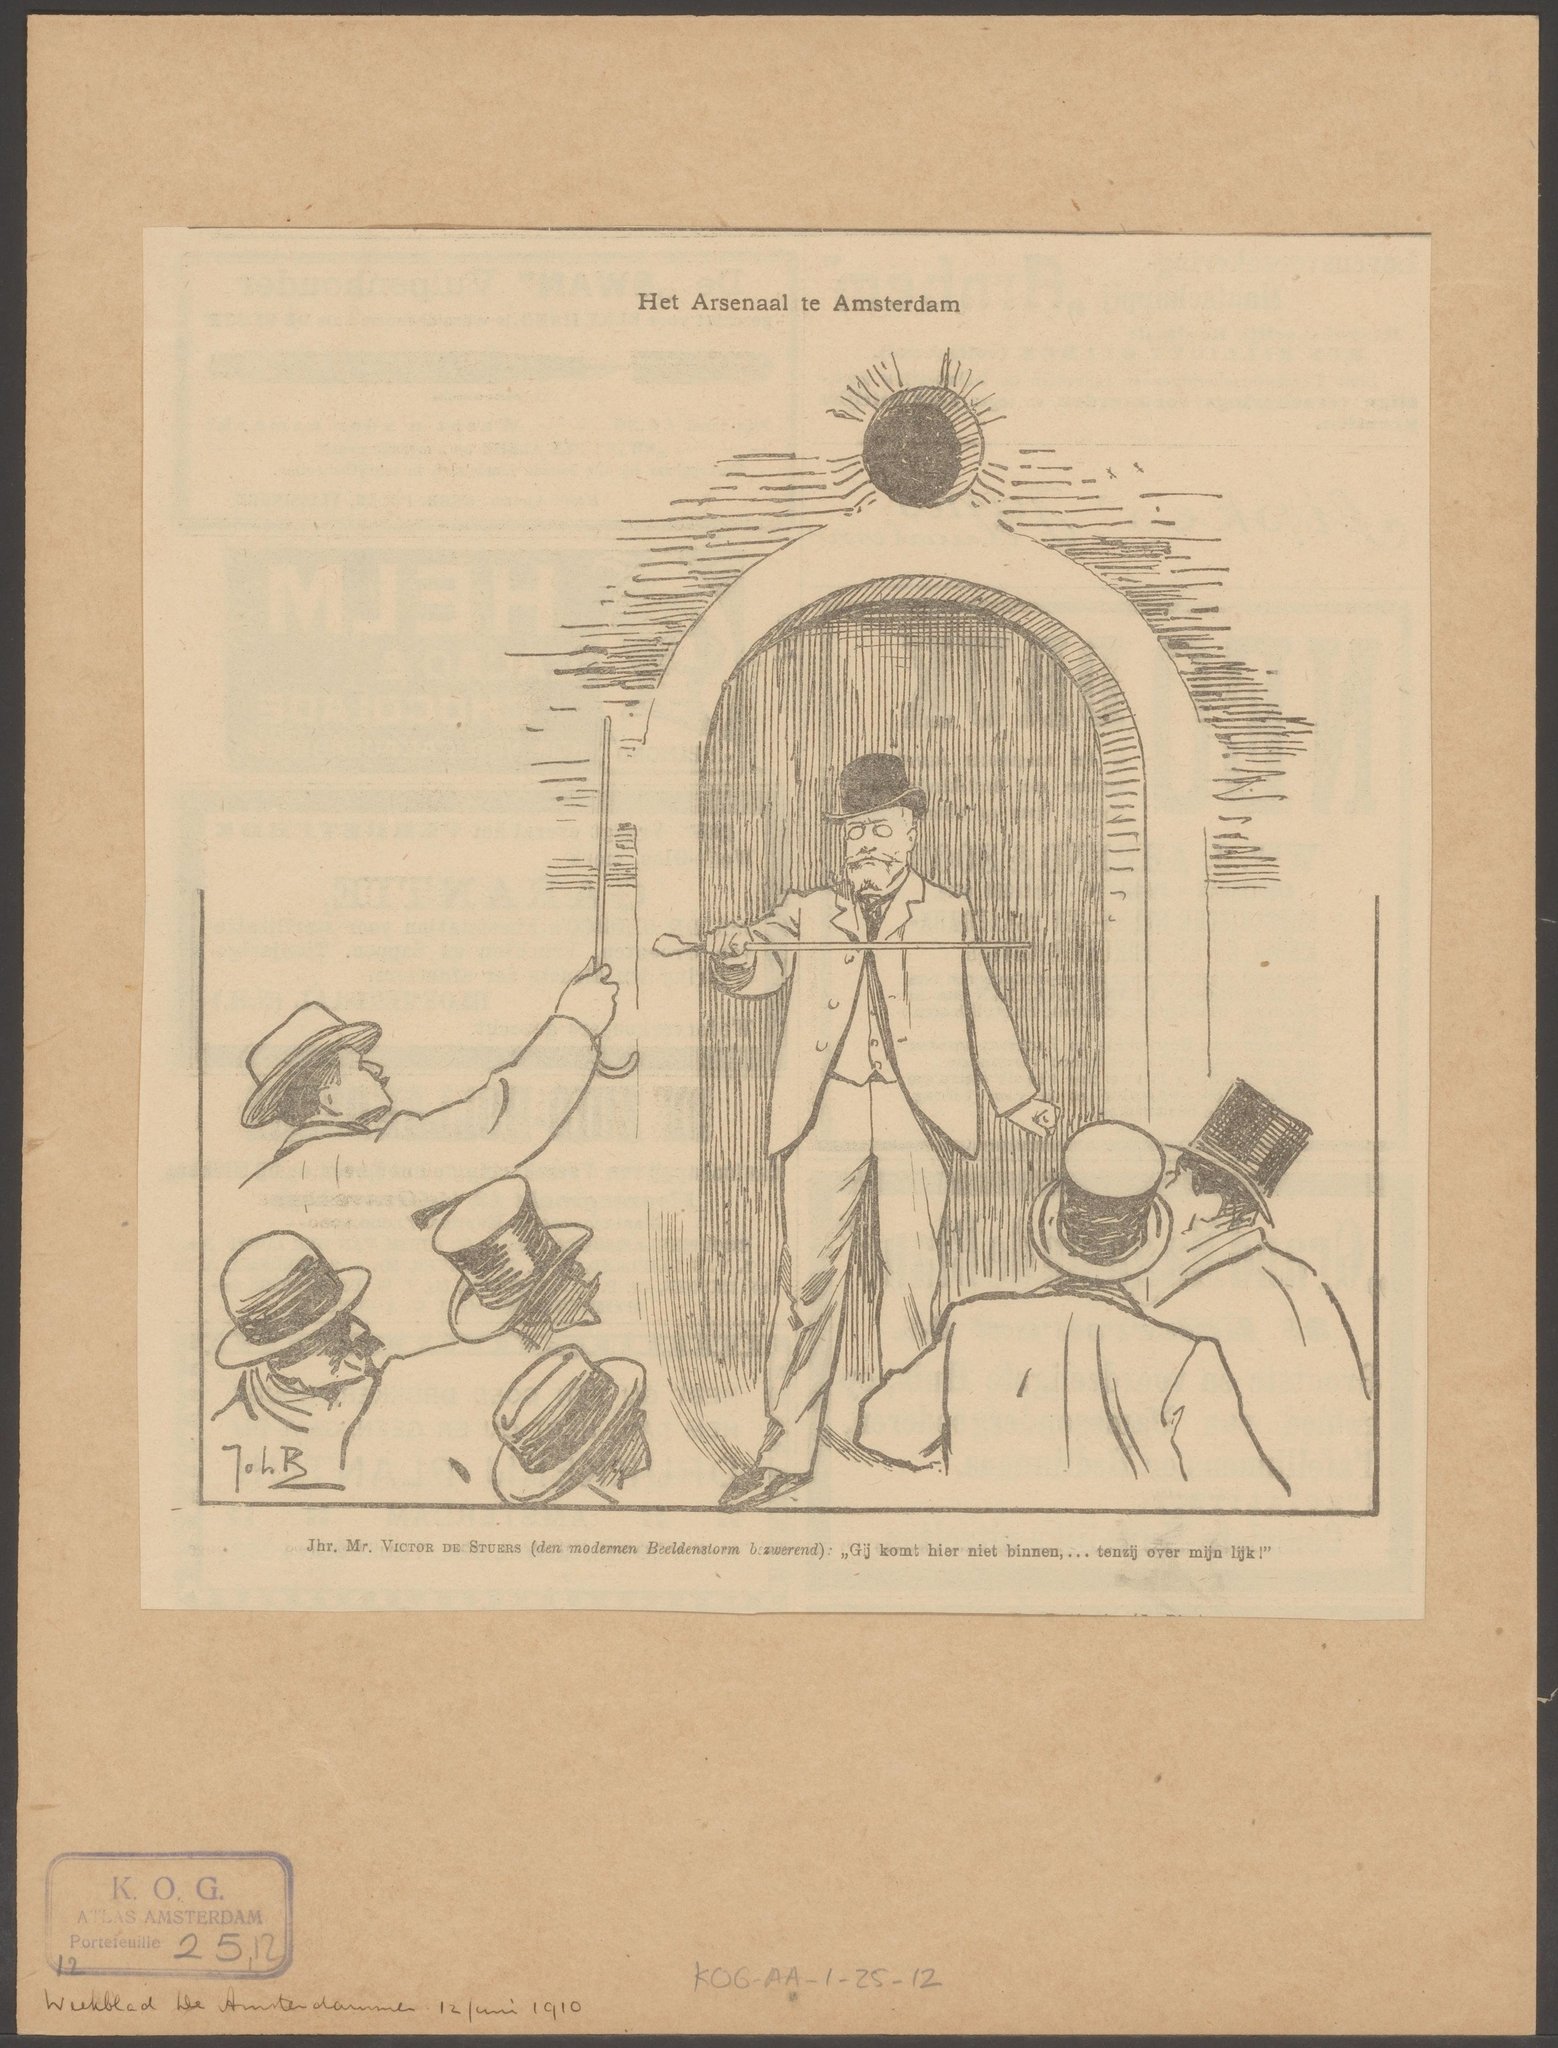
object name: photomechanical print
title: Het Arsenaal te Amsterdam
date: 1910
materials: paper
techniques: letterpress printing, line block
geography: amsterdam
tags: the hague, politician, victor de stuers, large-scale structure for storage, e.g.: warehouse, depot, silo, gate, entrance, façade (of house or building)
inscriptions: collector's mark: Lugt 1641b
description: Onderwerpsrubriek binnen de Atlas Amsterdam: Krijgswezen I: De Admiraliteit van Amsterdam, A. Admiraliteitsgebouwen.